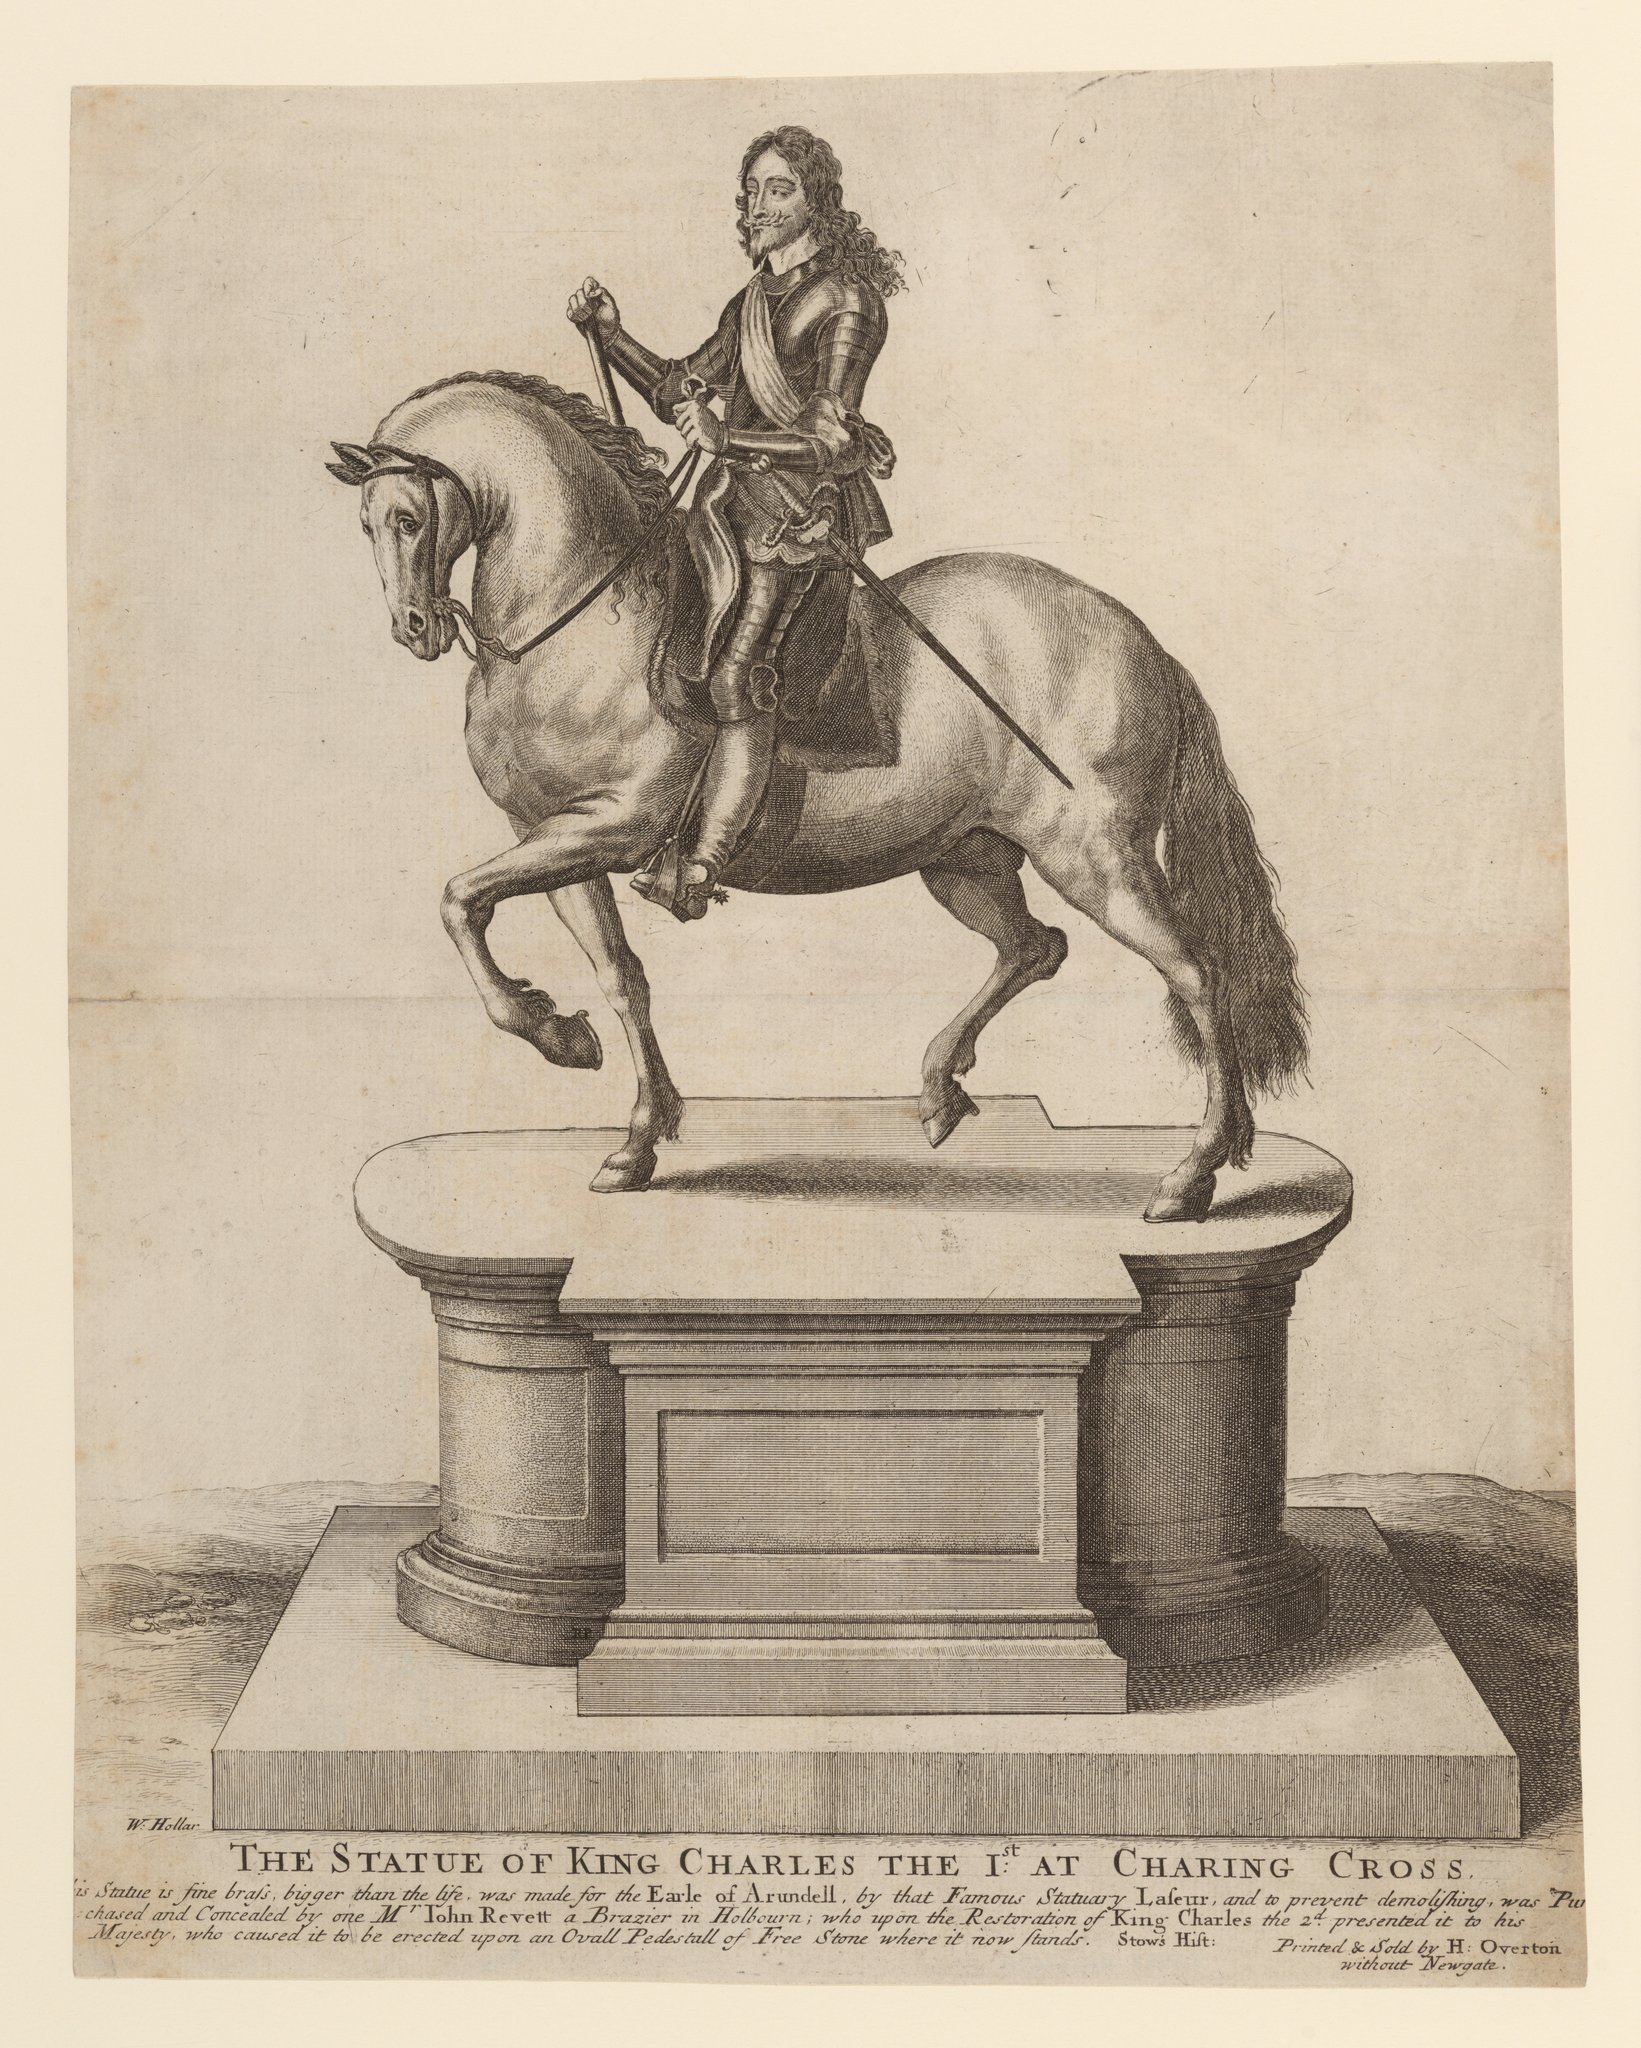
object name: print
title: Equestrian Statue of King Charles I at Charing Cross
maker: wenceslaus hollar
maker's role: artist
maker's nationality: bohemian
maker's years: 1607-1677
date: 1660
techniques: engraving, etching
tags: kings,horses